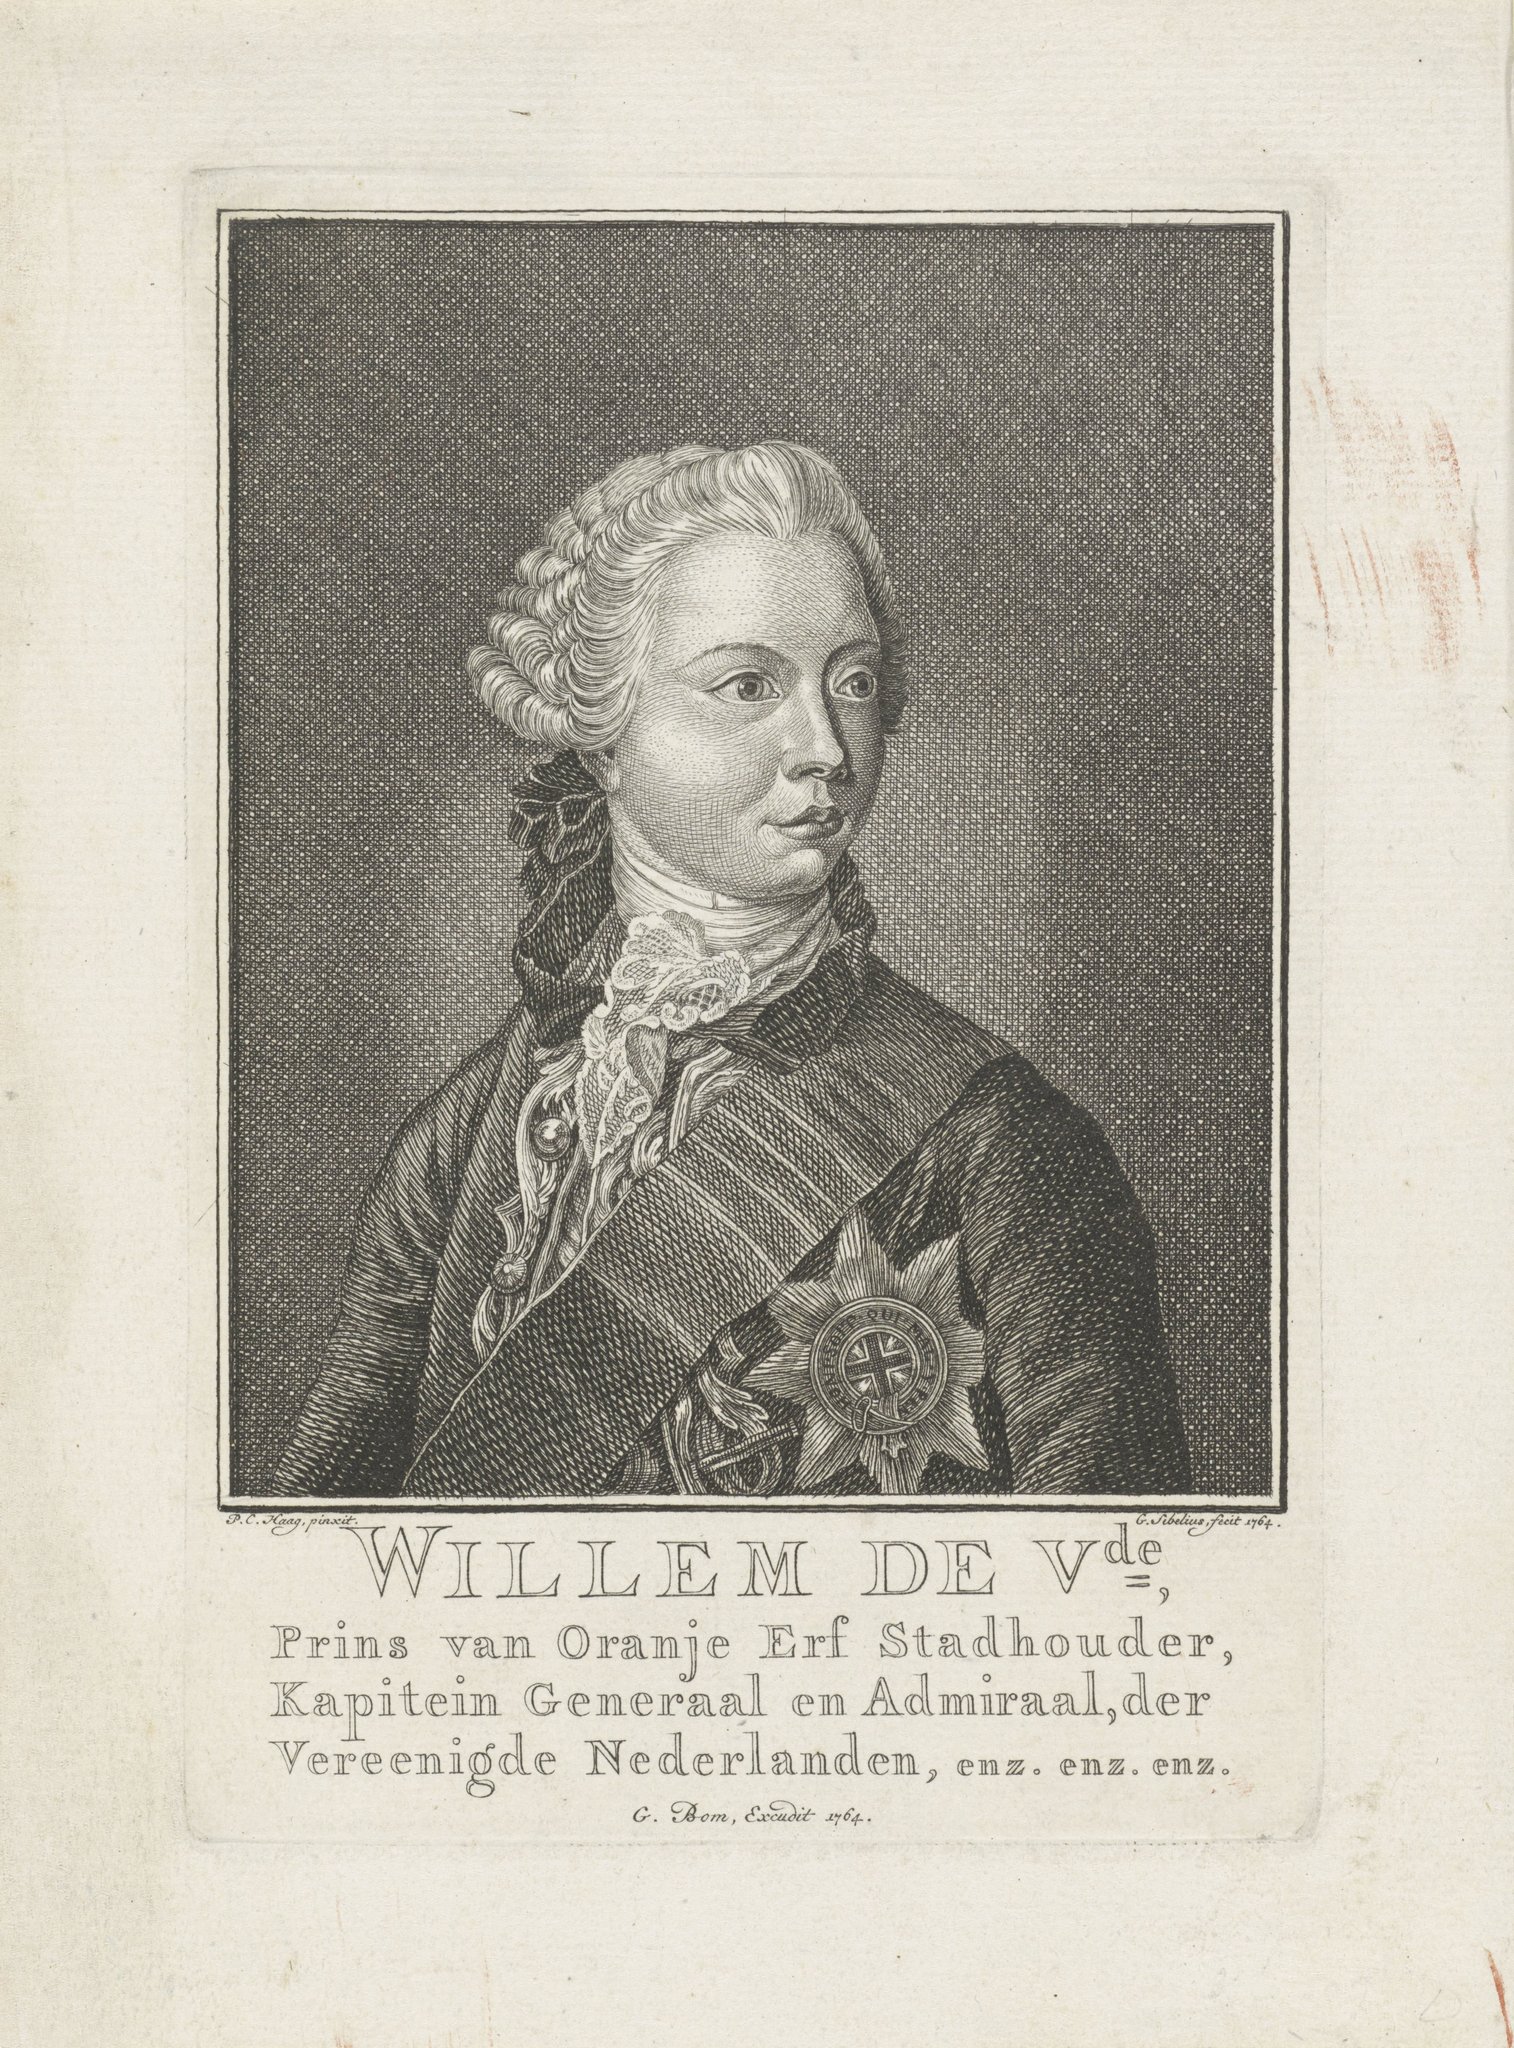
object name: print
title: Portret van Willem IV, prins van Oranje-Nassau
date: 1764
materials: paper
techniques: engraving, etching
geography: amsterdam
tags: the hague, william v (prince of orange), knighthood order (garter) - insignia of a knighthood order, e.g.: badge, chain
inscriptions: collector's mark: Lugt 2228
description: De hier vermelde titel verwijst naar de hoogst verkregen titel van de geportretteerde, niet per se naar de titel die de geportretteerde op deze voorstelling draagt.